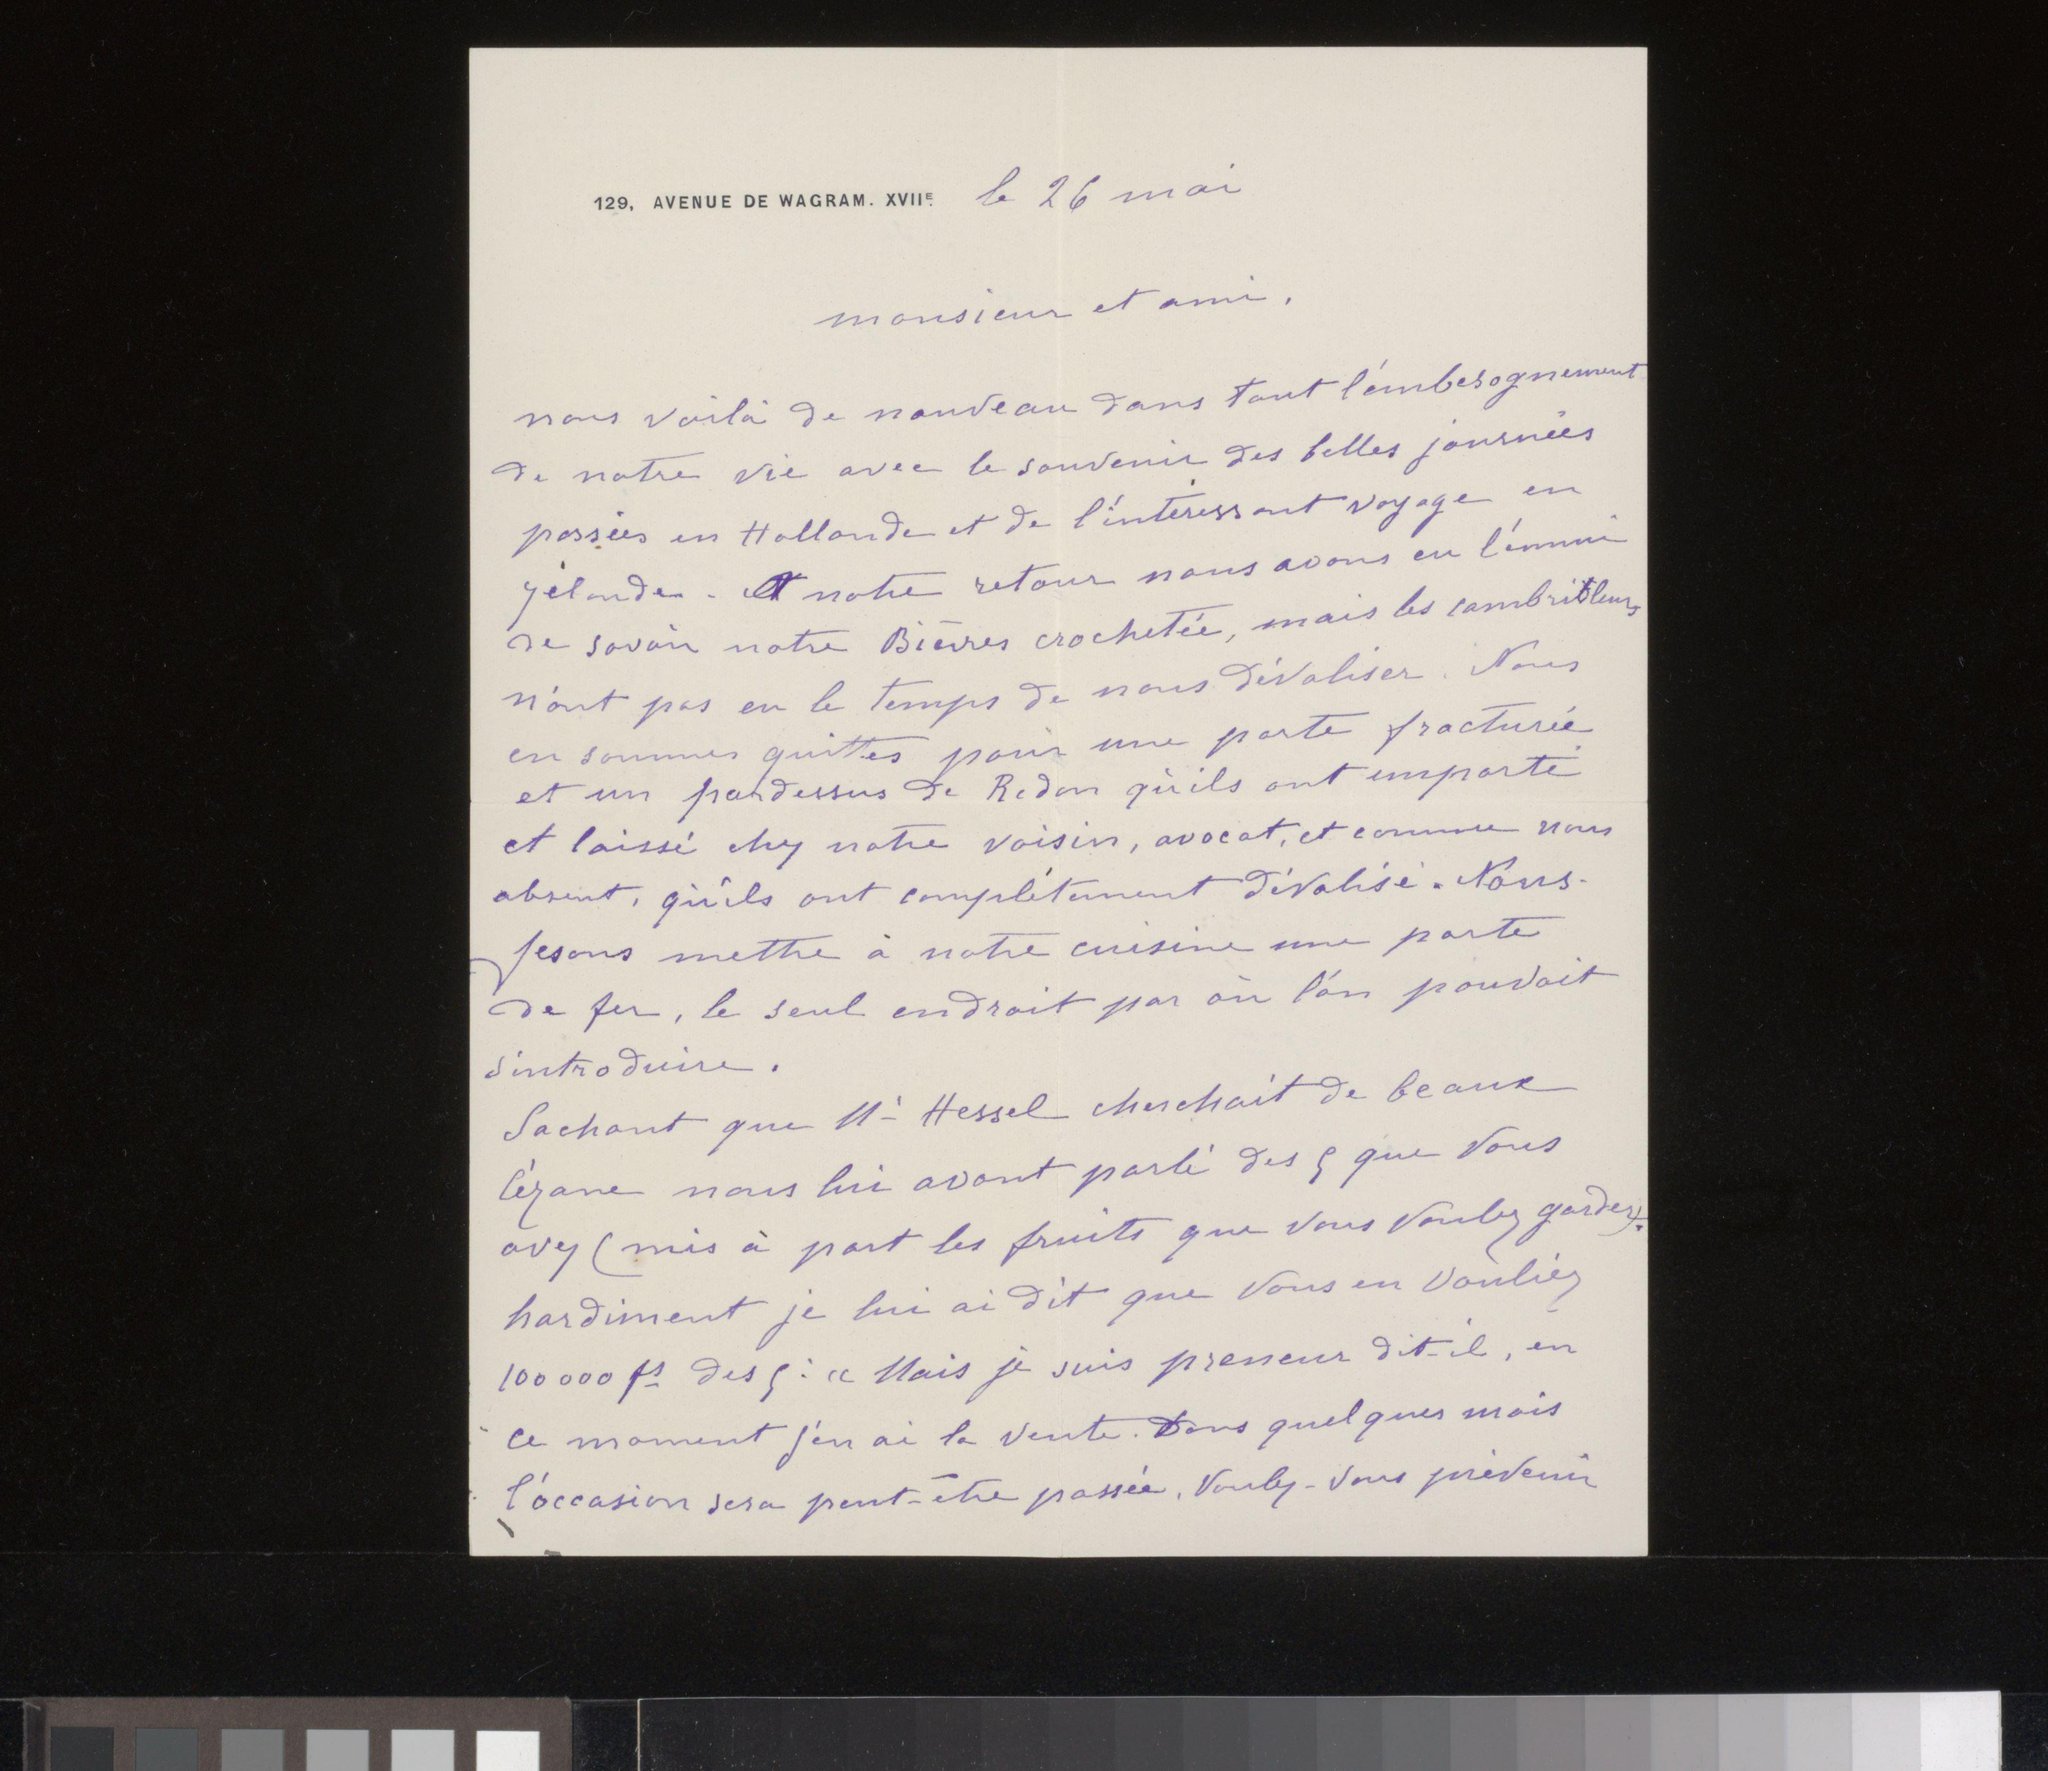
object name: letter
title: Brief aan Andries Bonger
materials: ink, paper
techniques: pen, writing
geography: paris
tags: paris, painter, print maker, draughtsman, odilon redon, amsterdam, andries bonger, money, middelburg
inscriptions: watermark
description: Brief behoort tot een album samengesteld door weduwe Françoise W.M. Barones van der Borch van Verwolde met afschriften van brieven met betrekking tot (de familie van) Odilon Redon. De brief werd bewaard op pagina 101.